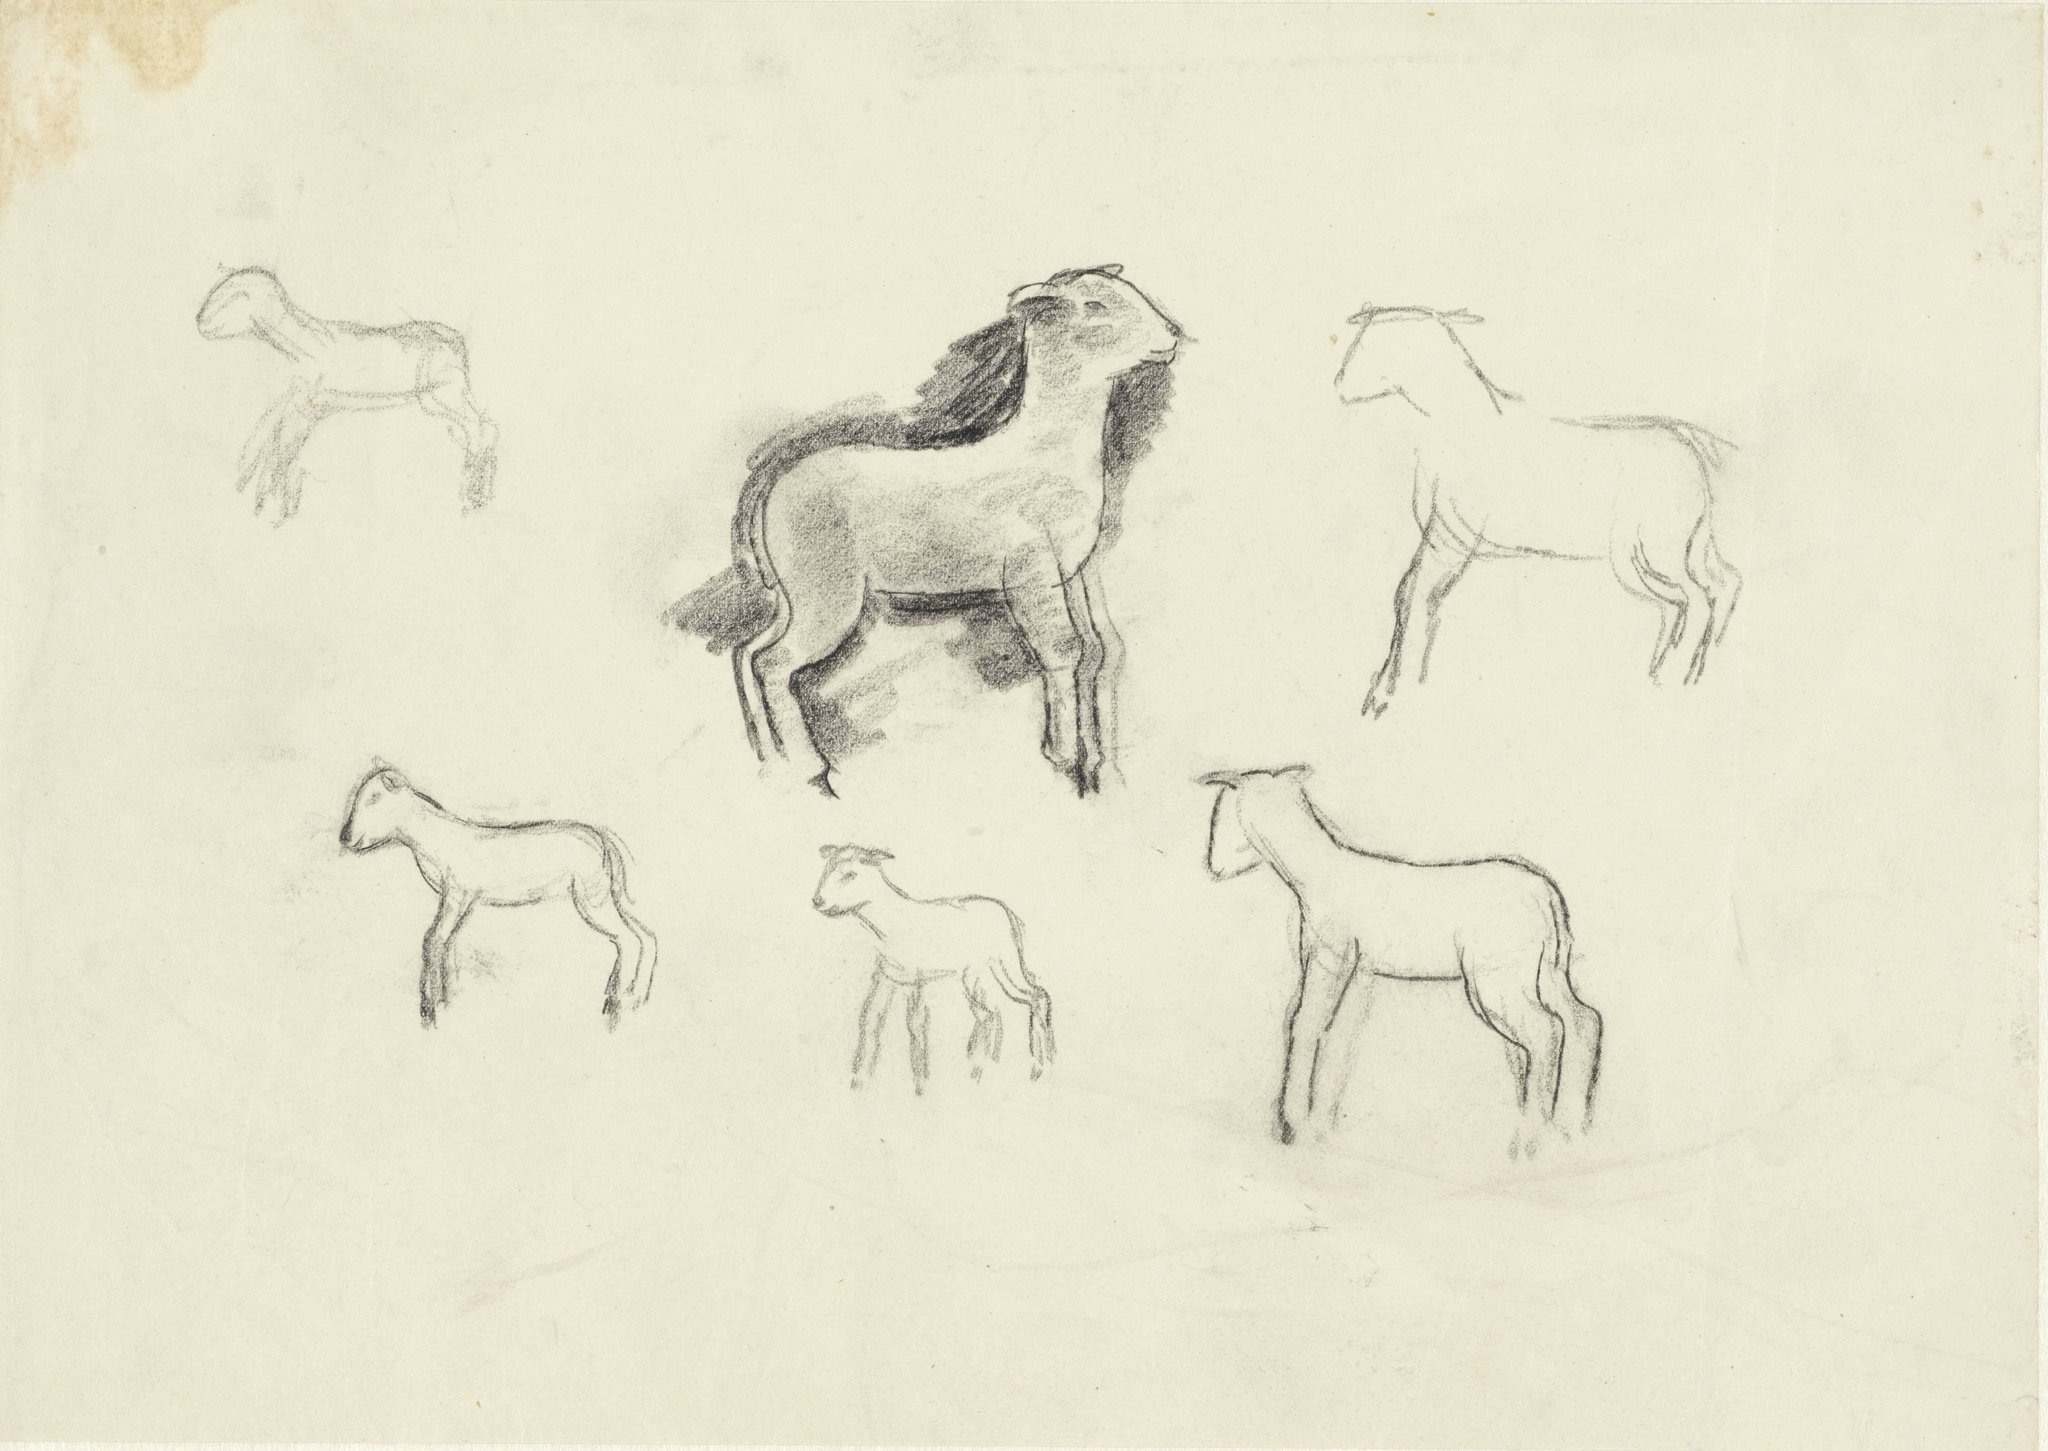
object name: drawing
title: Zes lammeren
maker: henk henriët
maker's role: draughtsman, print maker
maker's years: 1903-1945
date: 1913-1945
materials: chalk, paper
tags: lamb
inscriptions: collector's mark: Lugt 2228